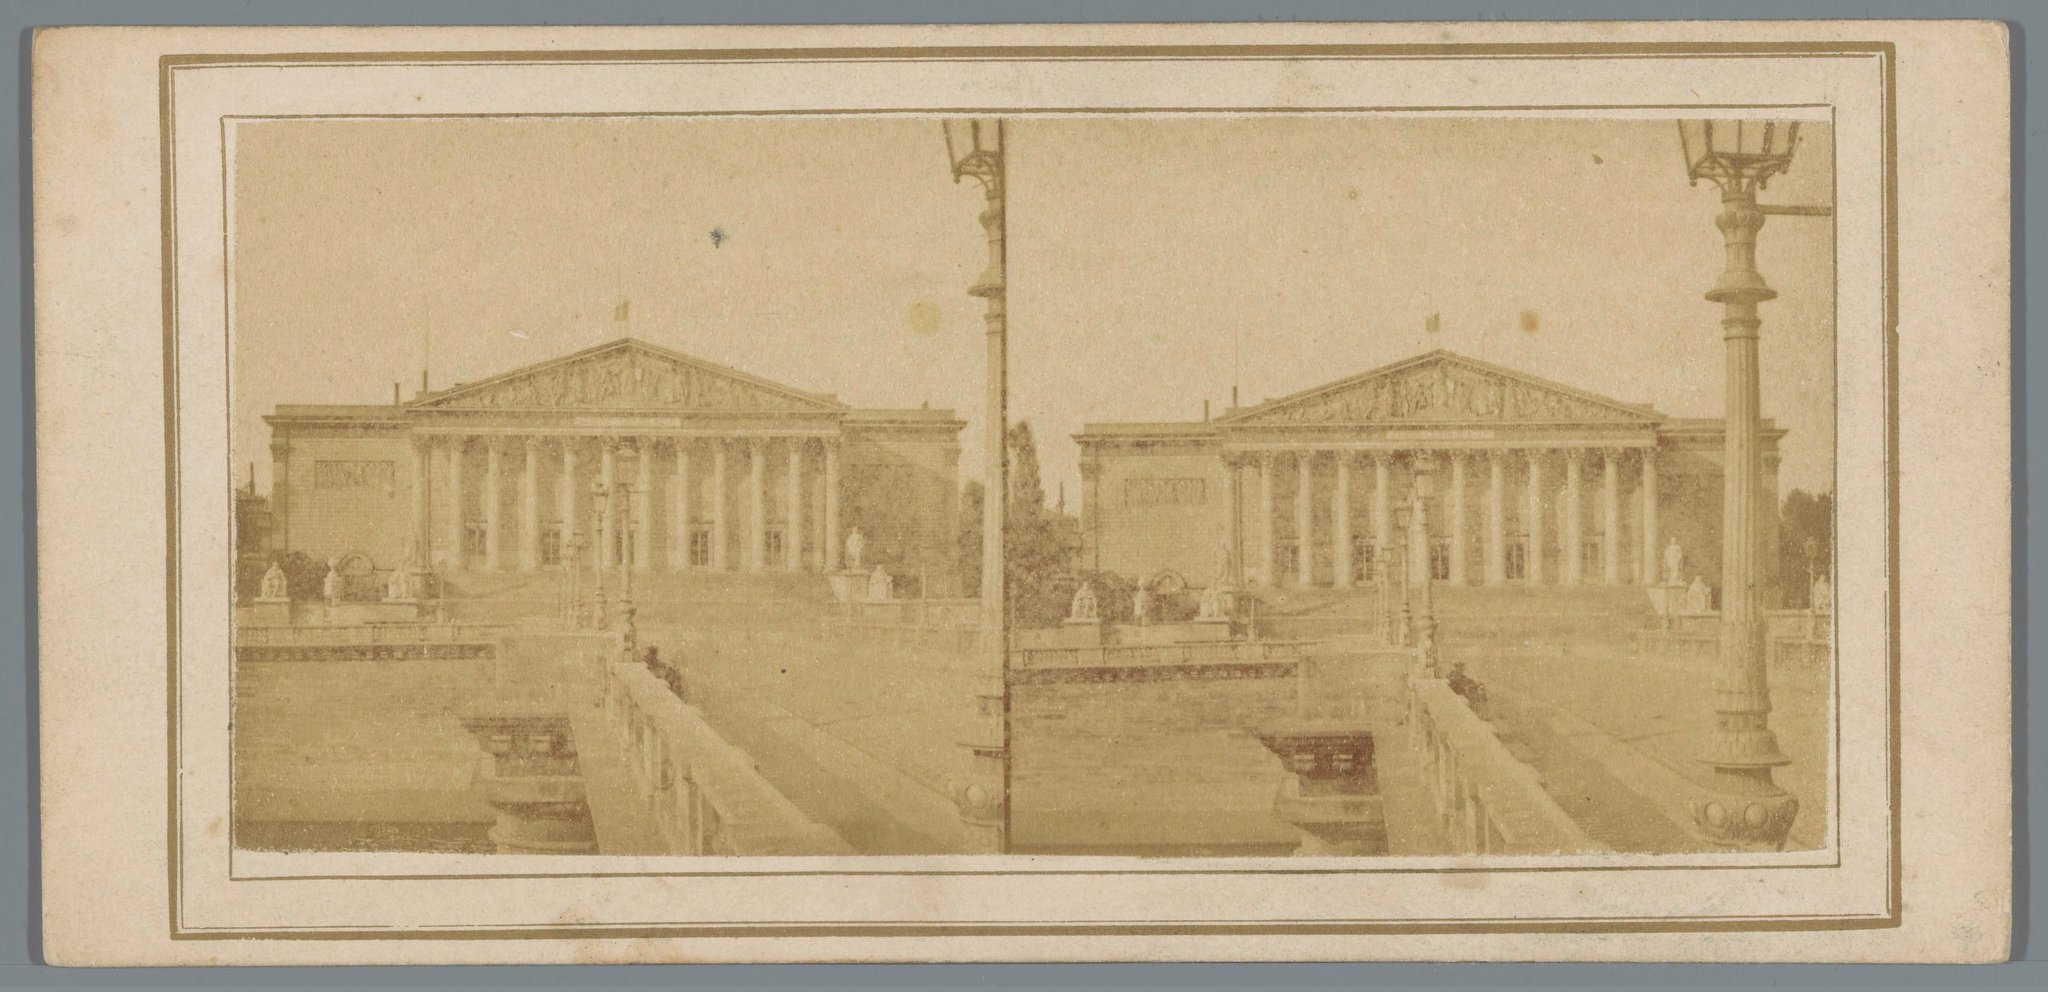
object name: stereograph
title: Gezicht op het Palais Bourbon in Parijs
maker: Anonymous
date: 1855-1860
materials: cardboard, photographic support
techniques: albumen print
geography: paris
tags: palace, façade (of house or building)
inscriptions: inscription: ‘Chambre des Deputés’, number: ‘No. 14.’